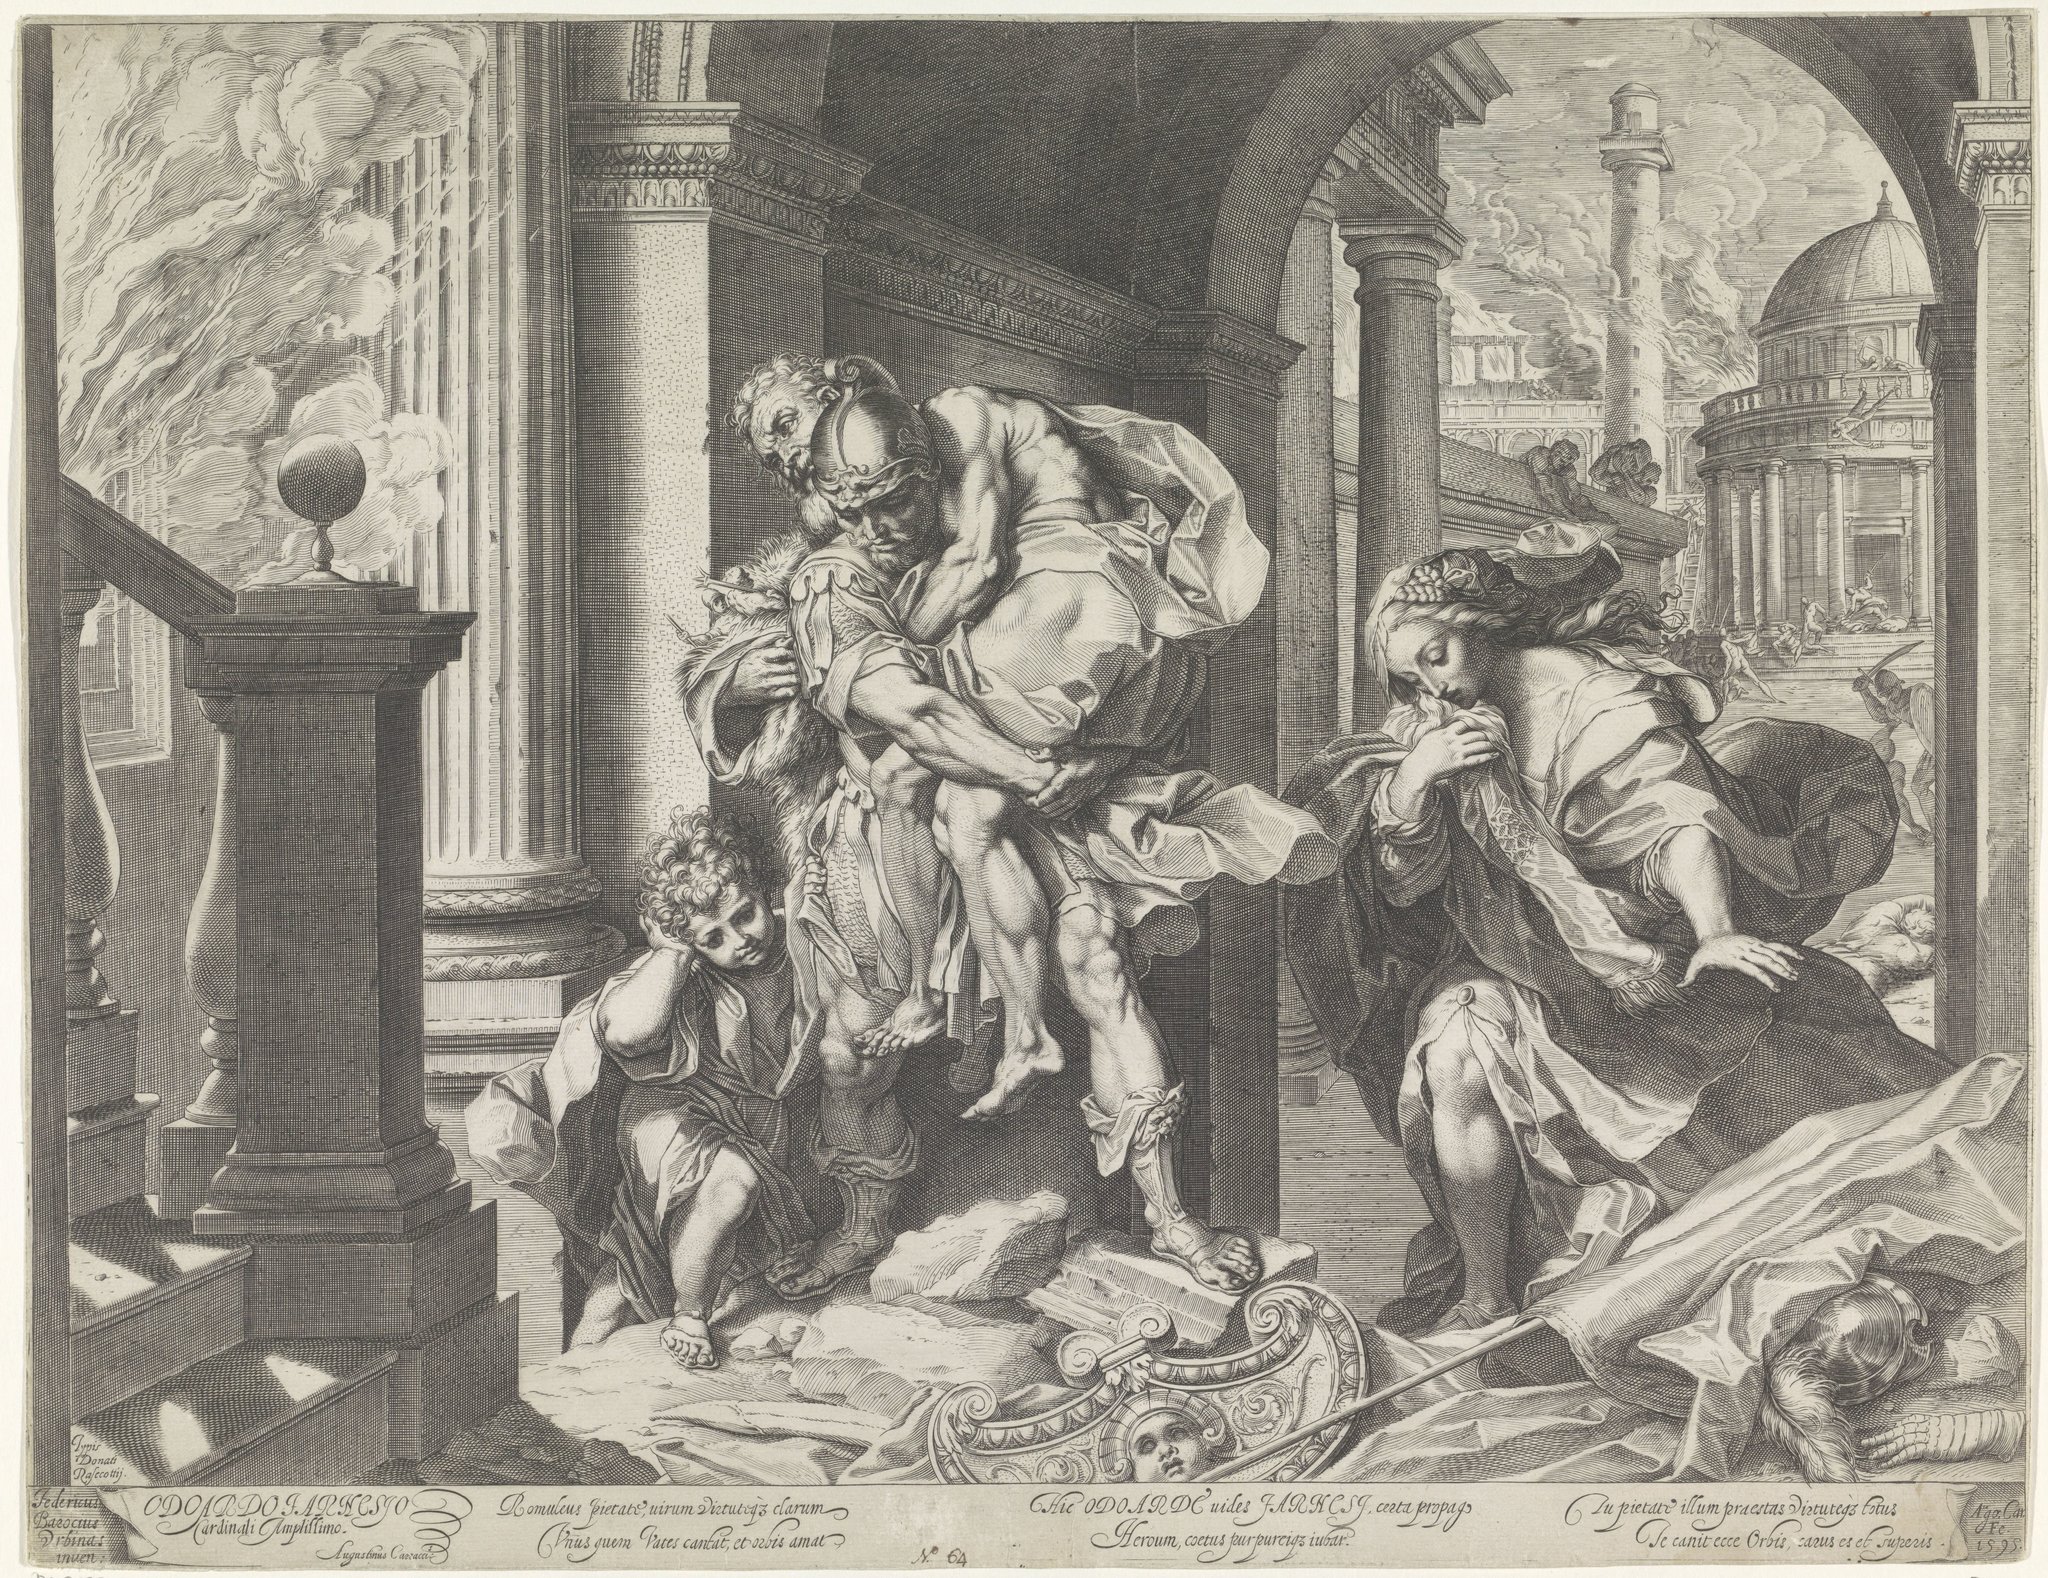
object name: print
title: Aeneas vlucht met zijn familie uit Troje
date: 1595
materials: paper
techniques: engraving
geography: italy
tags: 'pius aeneas': aeneas, leading ascanius, escapes from burning troy, carrying his father anchises with the penates; his wife creusa, who sets out with them, is lost on the way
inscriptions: collector's mark: Lugt 240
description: Naar een karton voor een schilderij in het Musée du Louvre te Parijs of naar een verloren gegaan schilderij voor het hof van Rudolf II te Praag door Federico Barocci. Een tweede versie van het schilderij door Barocci is wel over en hangt in de Galleria Borghese te Rome. Er is ook een studie in olieverf bewaard gebleven door Agostino Carracci in Windsor Castle te Windsor.